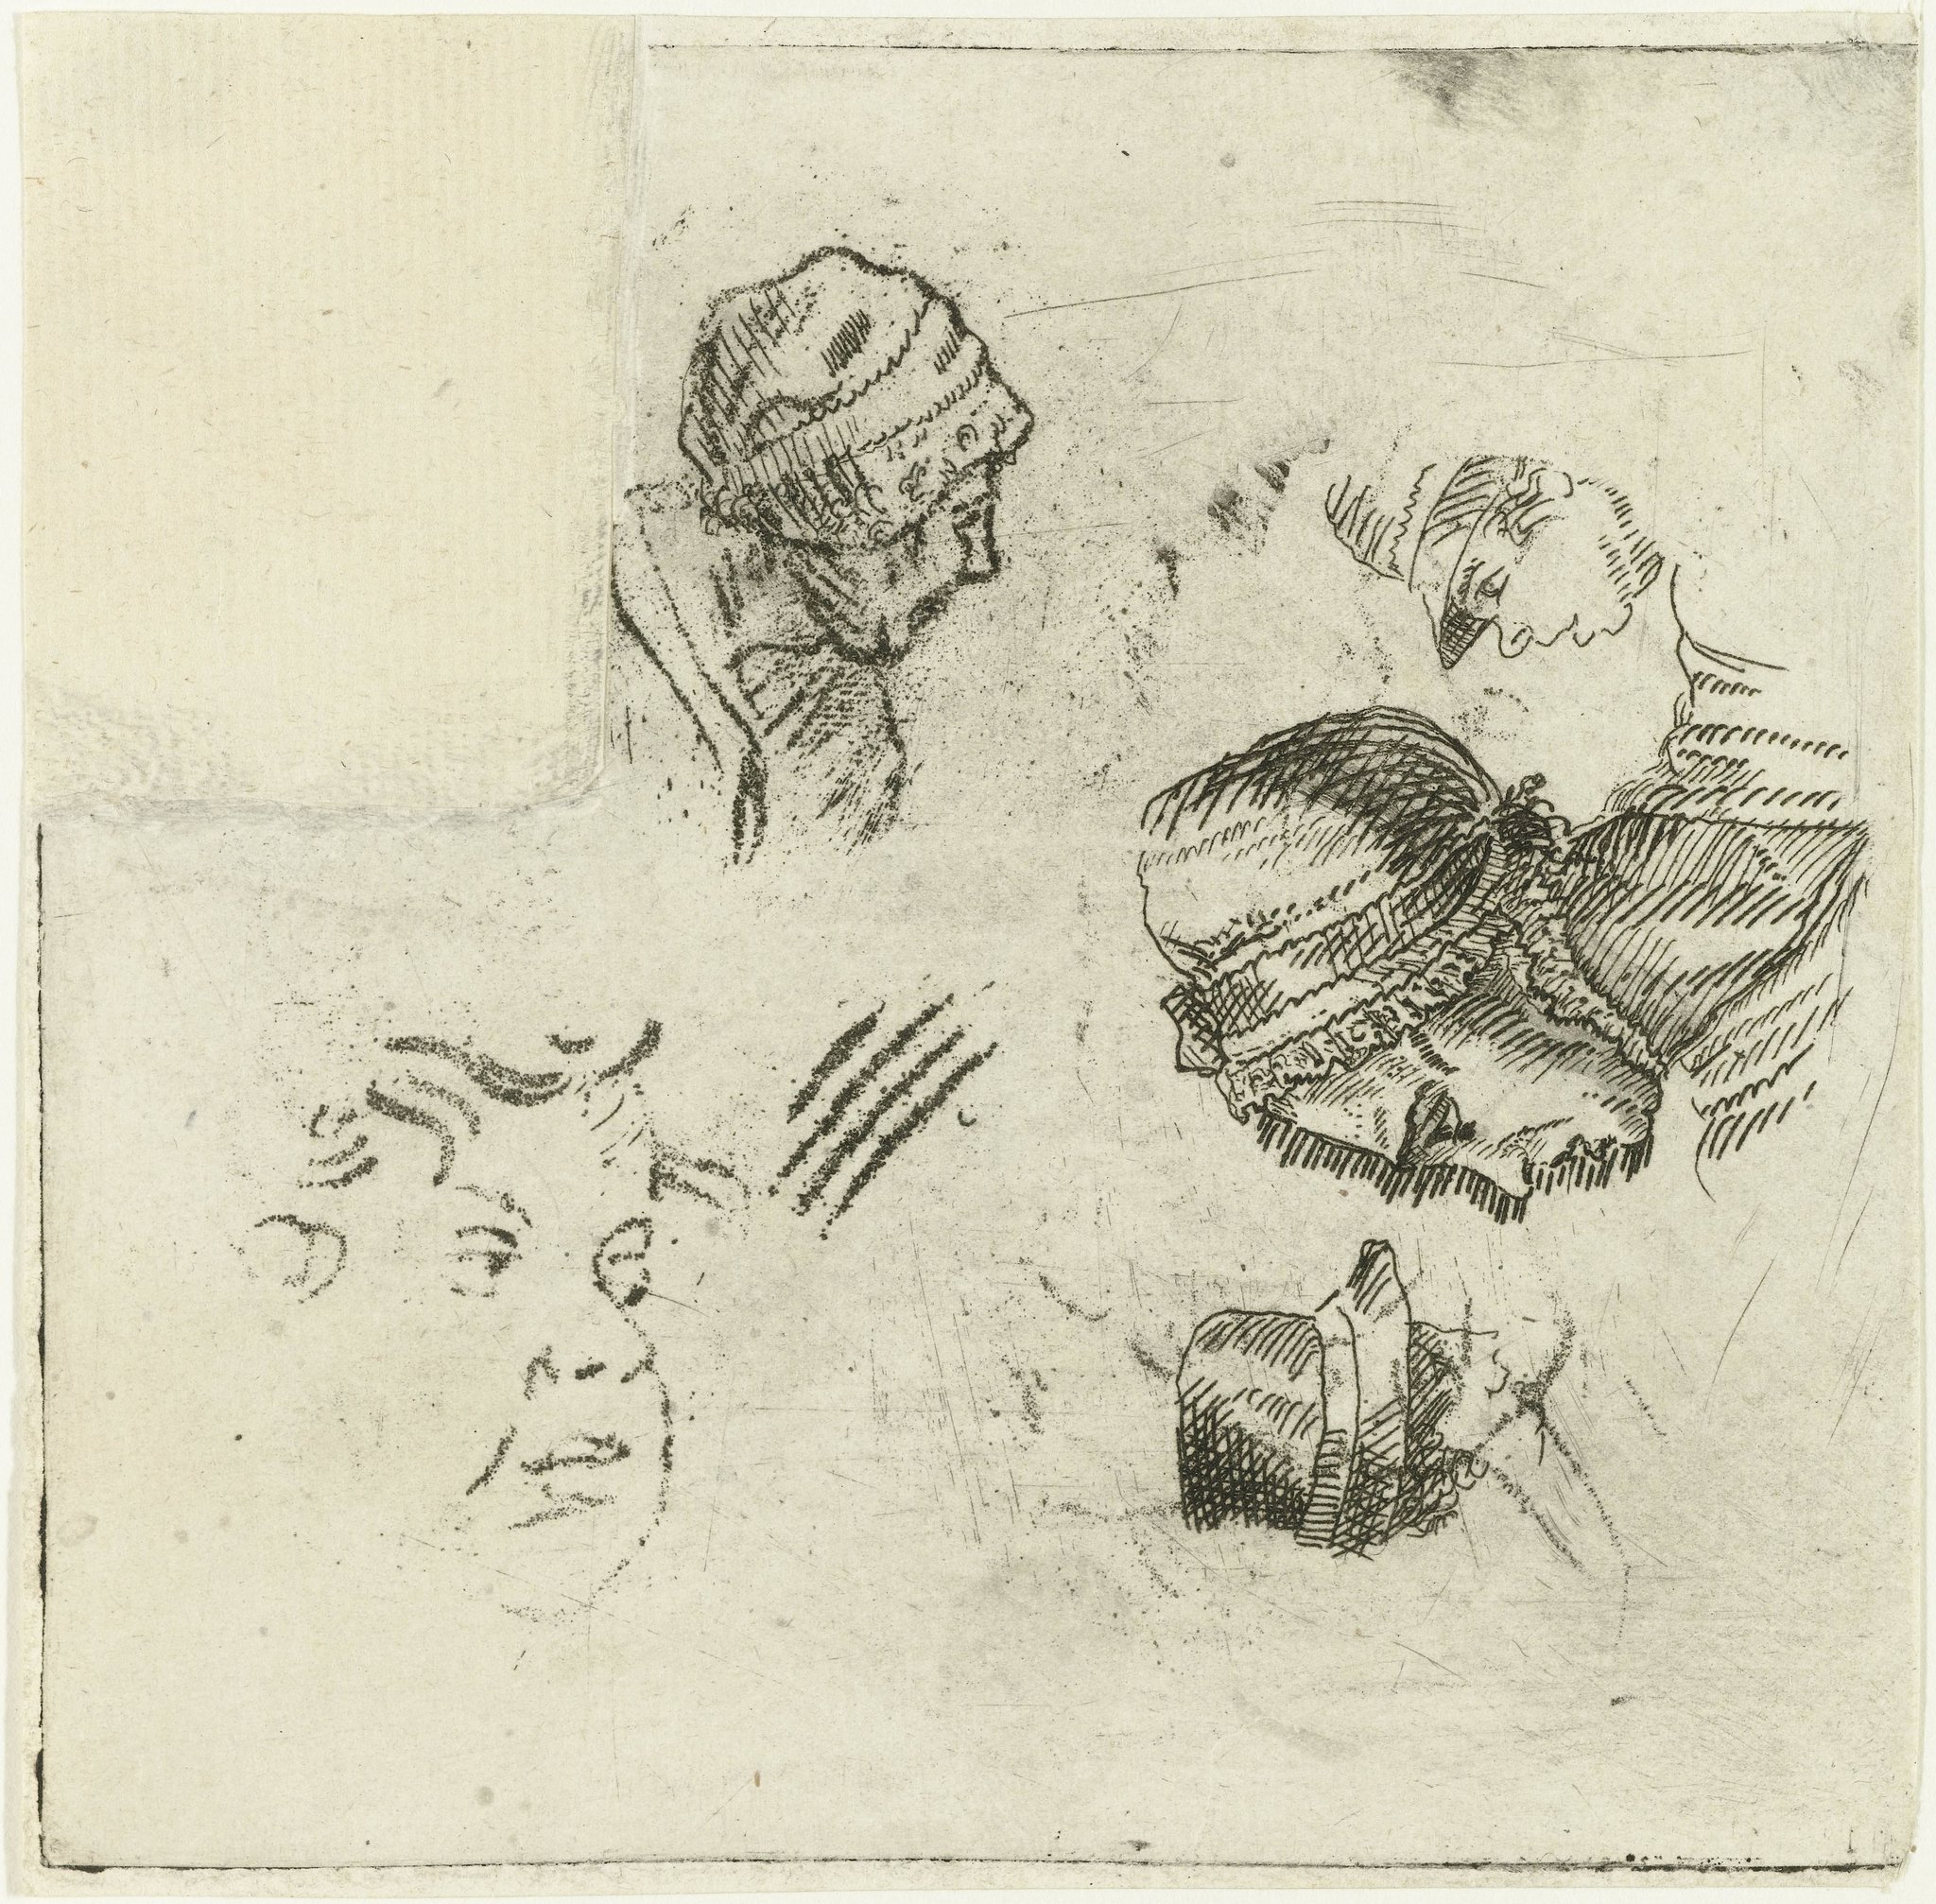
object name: print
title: Studieblad met vijf hoofden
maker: marie lambertine coclers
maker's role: conservator, draughtsman, print maker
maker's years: 1761-1815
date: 1776-1815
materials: paper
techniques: printmaking, etching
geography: amsterdam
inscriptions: collector's mark: Lugt 240